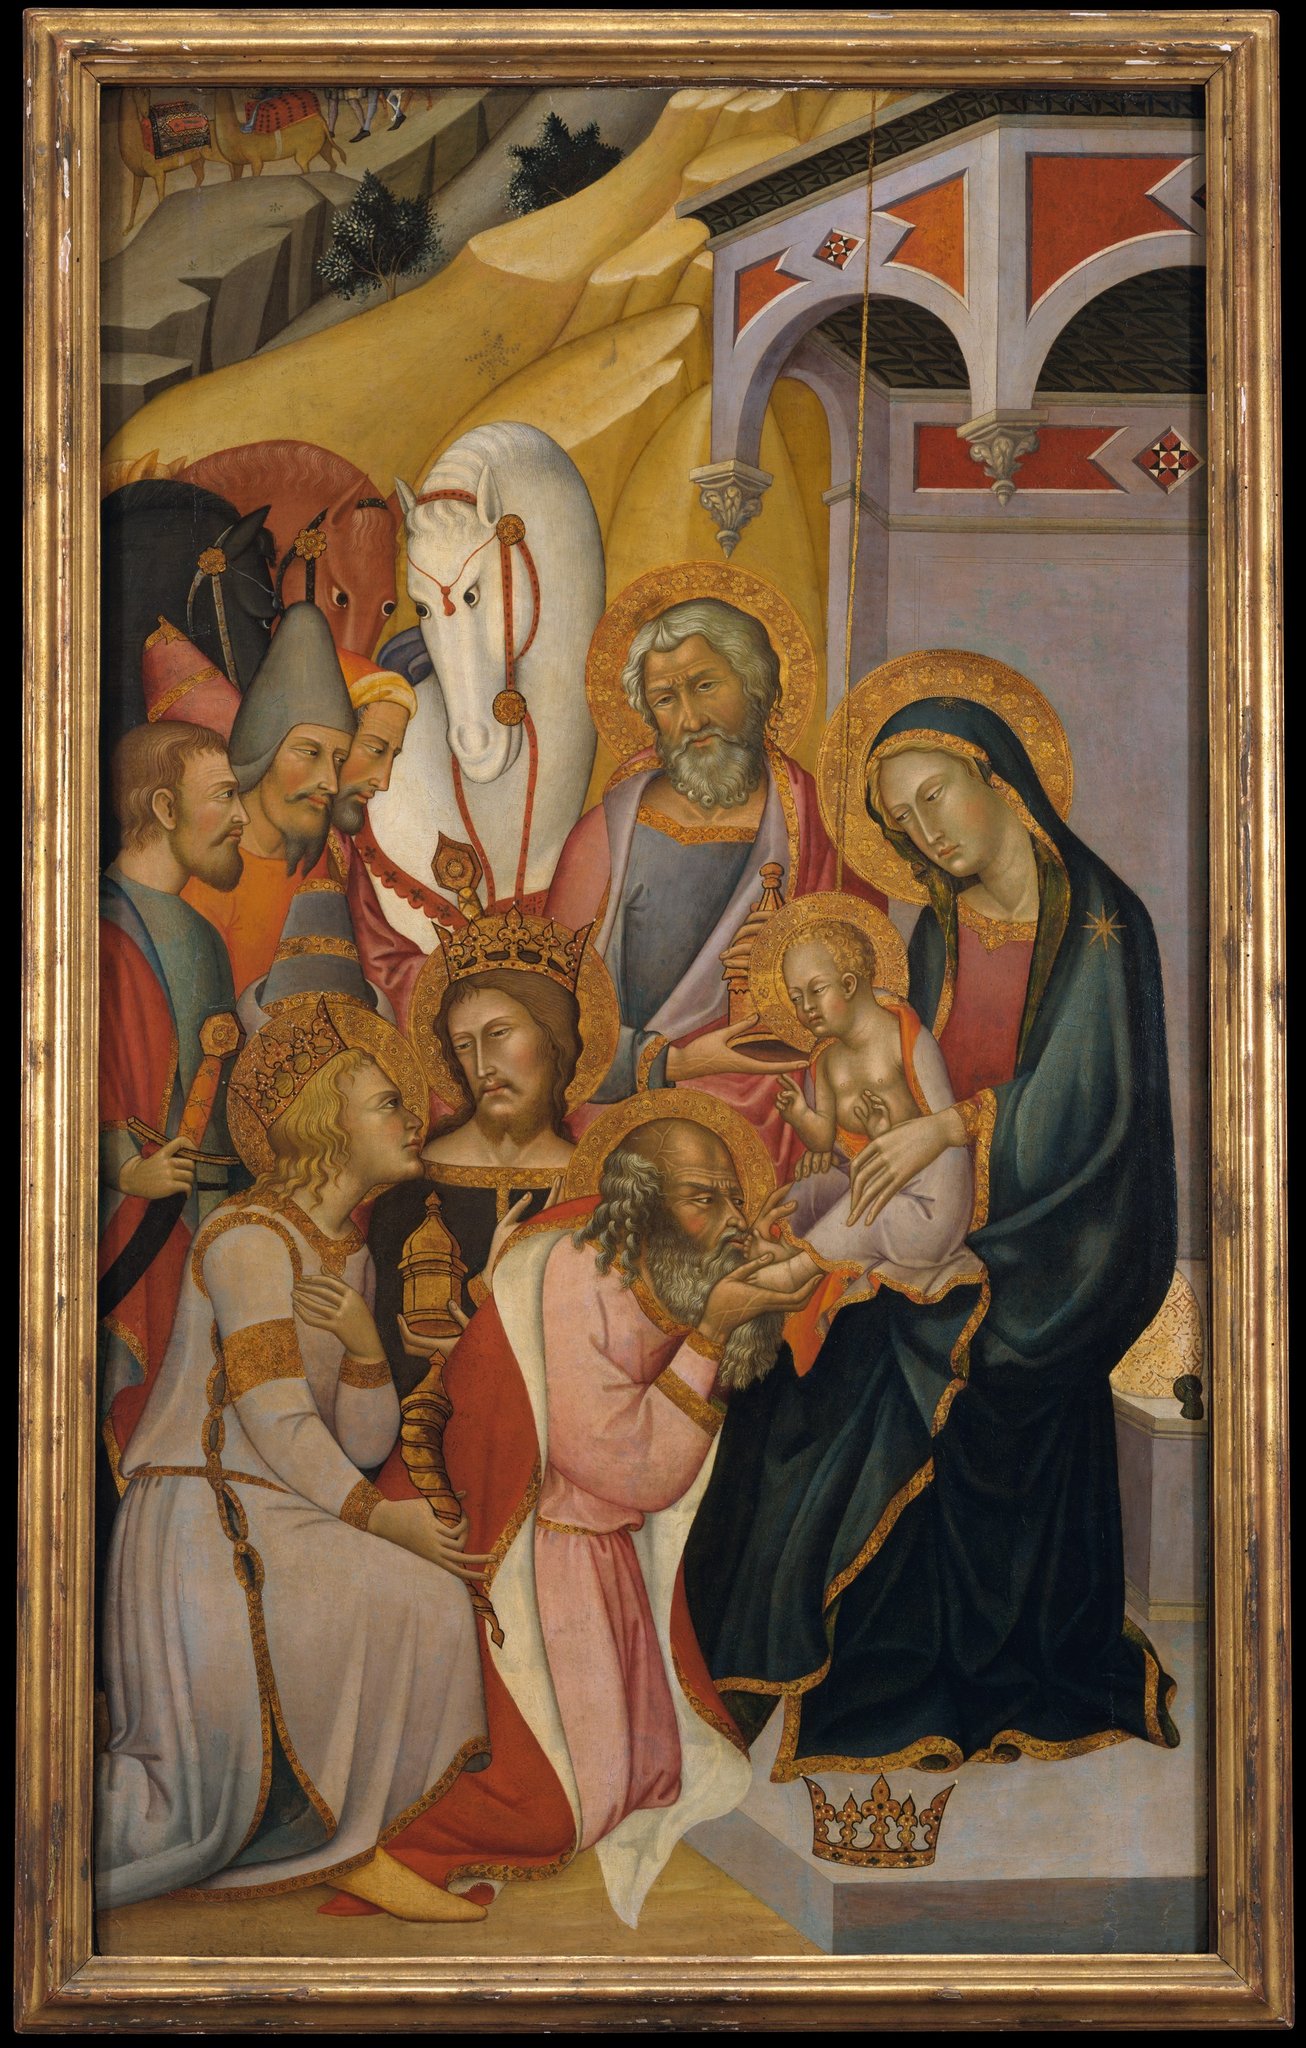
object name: painting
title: The Adoration of the Magi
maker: bartolo di fredi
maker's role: artist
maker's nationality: italian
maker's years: 1353-1410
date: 1390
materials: gold, paint, wood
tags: men,horses,madonna and child,adoration of the magi